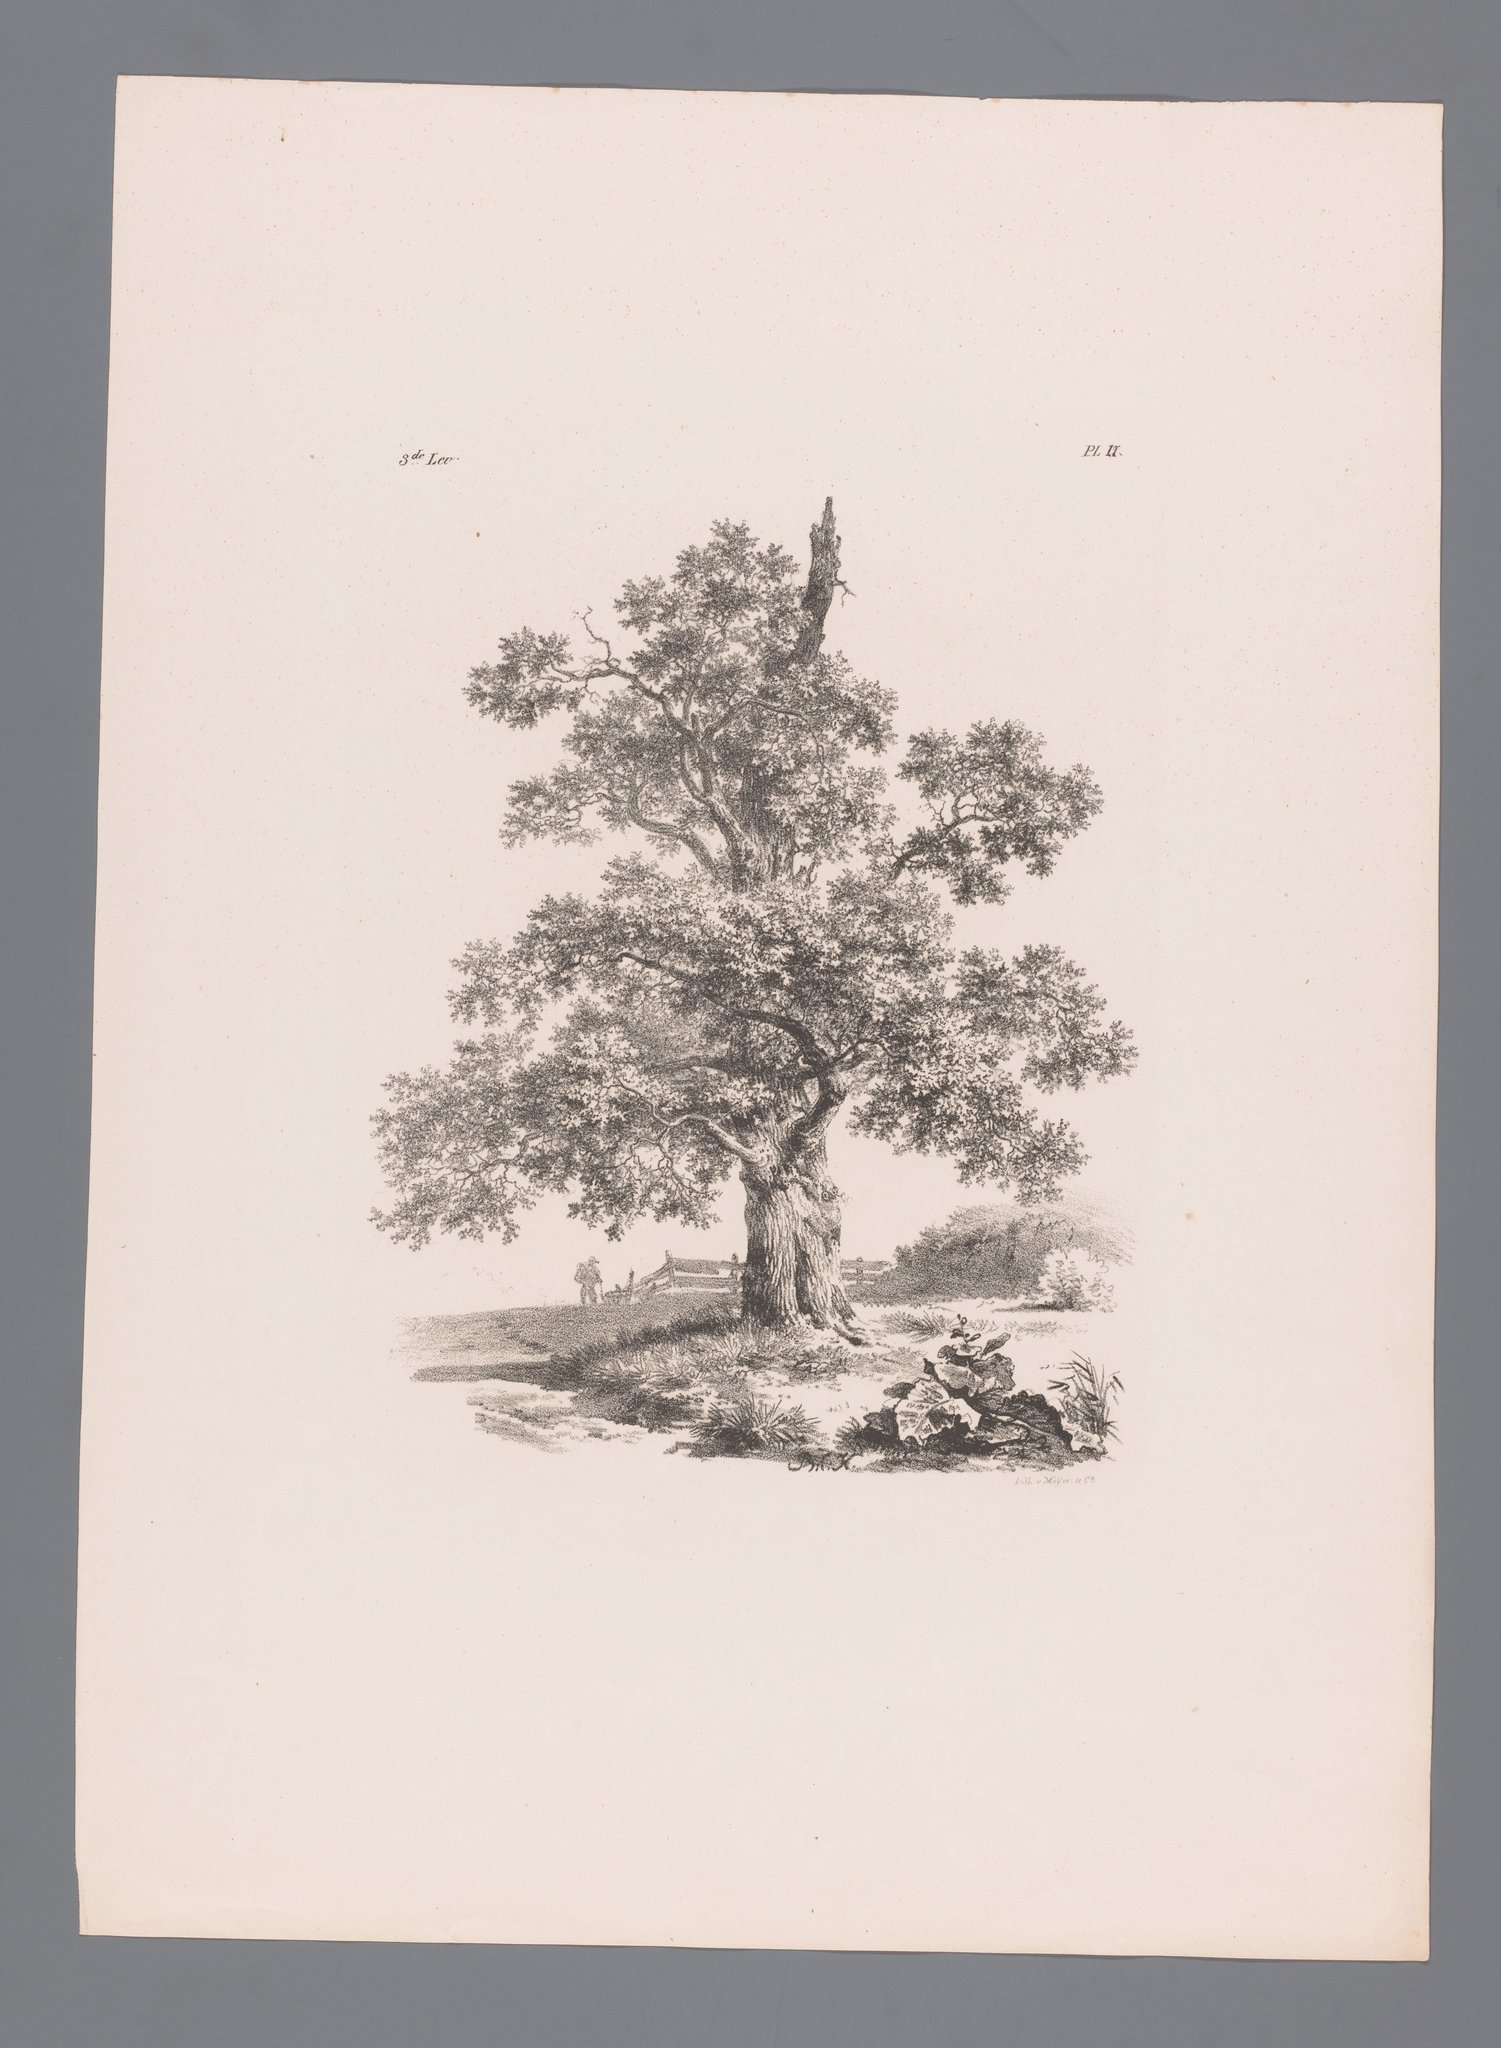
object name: print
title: Landschap studiën derde levering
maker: barend cornelis koekkoek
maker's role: draughtsman, painter, print maker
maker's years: 1803-1862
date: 1844-1845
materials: paper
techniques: lithograph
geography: amsterdam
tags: trees, fence, wall, paling, 'en route', traveller under way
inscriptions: collector's mark: Lugt 2228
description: In 1829 en 1830 gaf Koekkoek, samen met Daiwaille, zes cahiers uit met ieder zes prenten getiteld Landschapstudiën. Deze werden gebruikt in het tekenonderwijs. Vijftien jaar later werd deze reeks, in een andere samenstelling nogmaals uitgegeven door Meyer en Comp in Amsterdam. Zie: De Bruyn Kops, 1963.